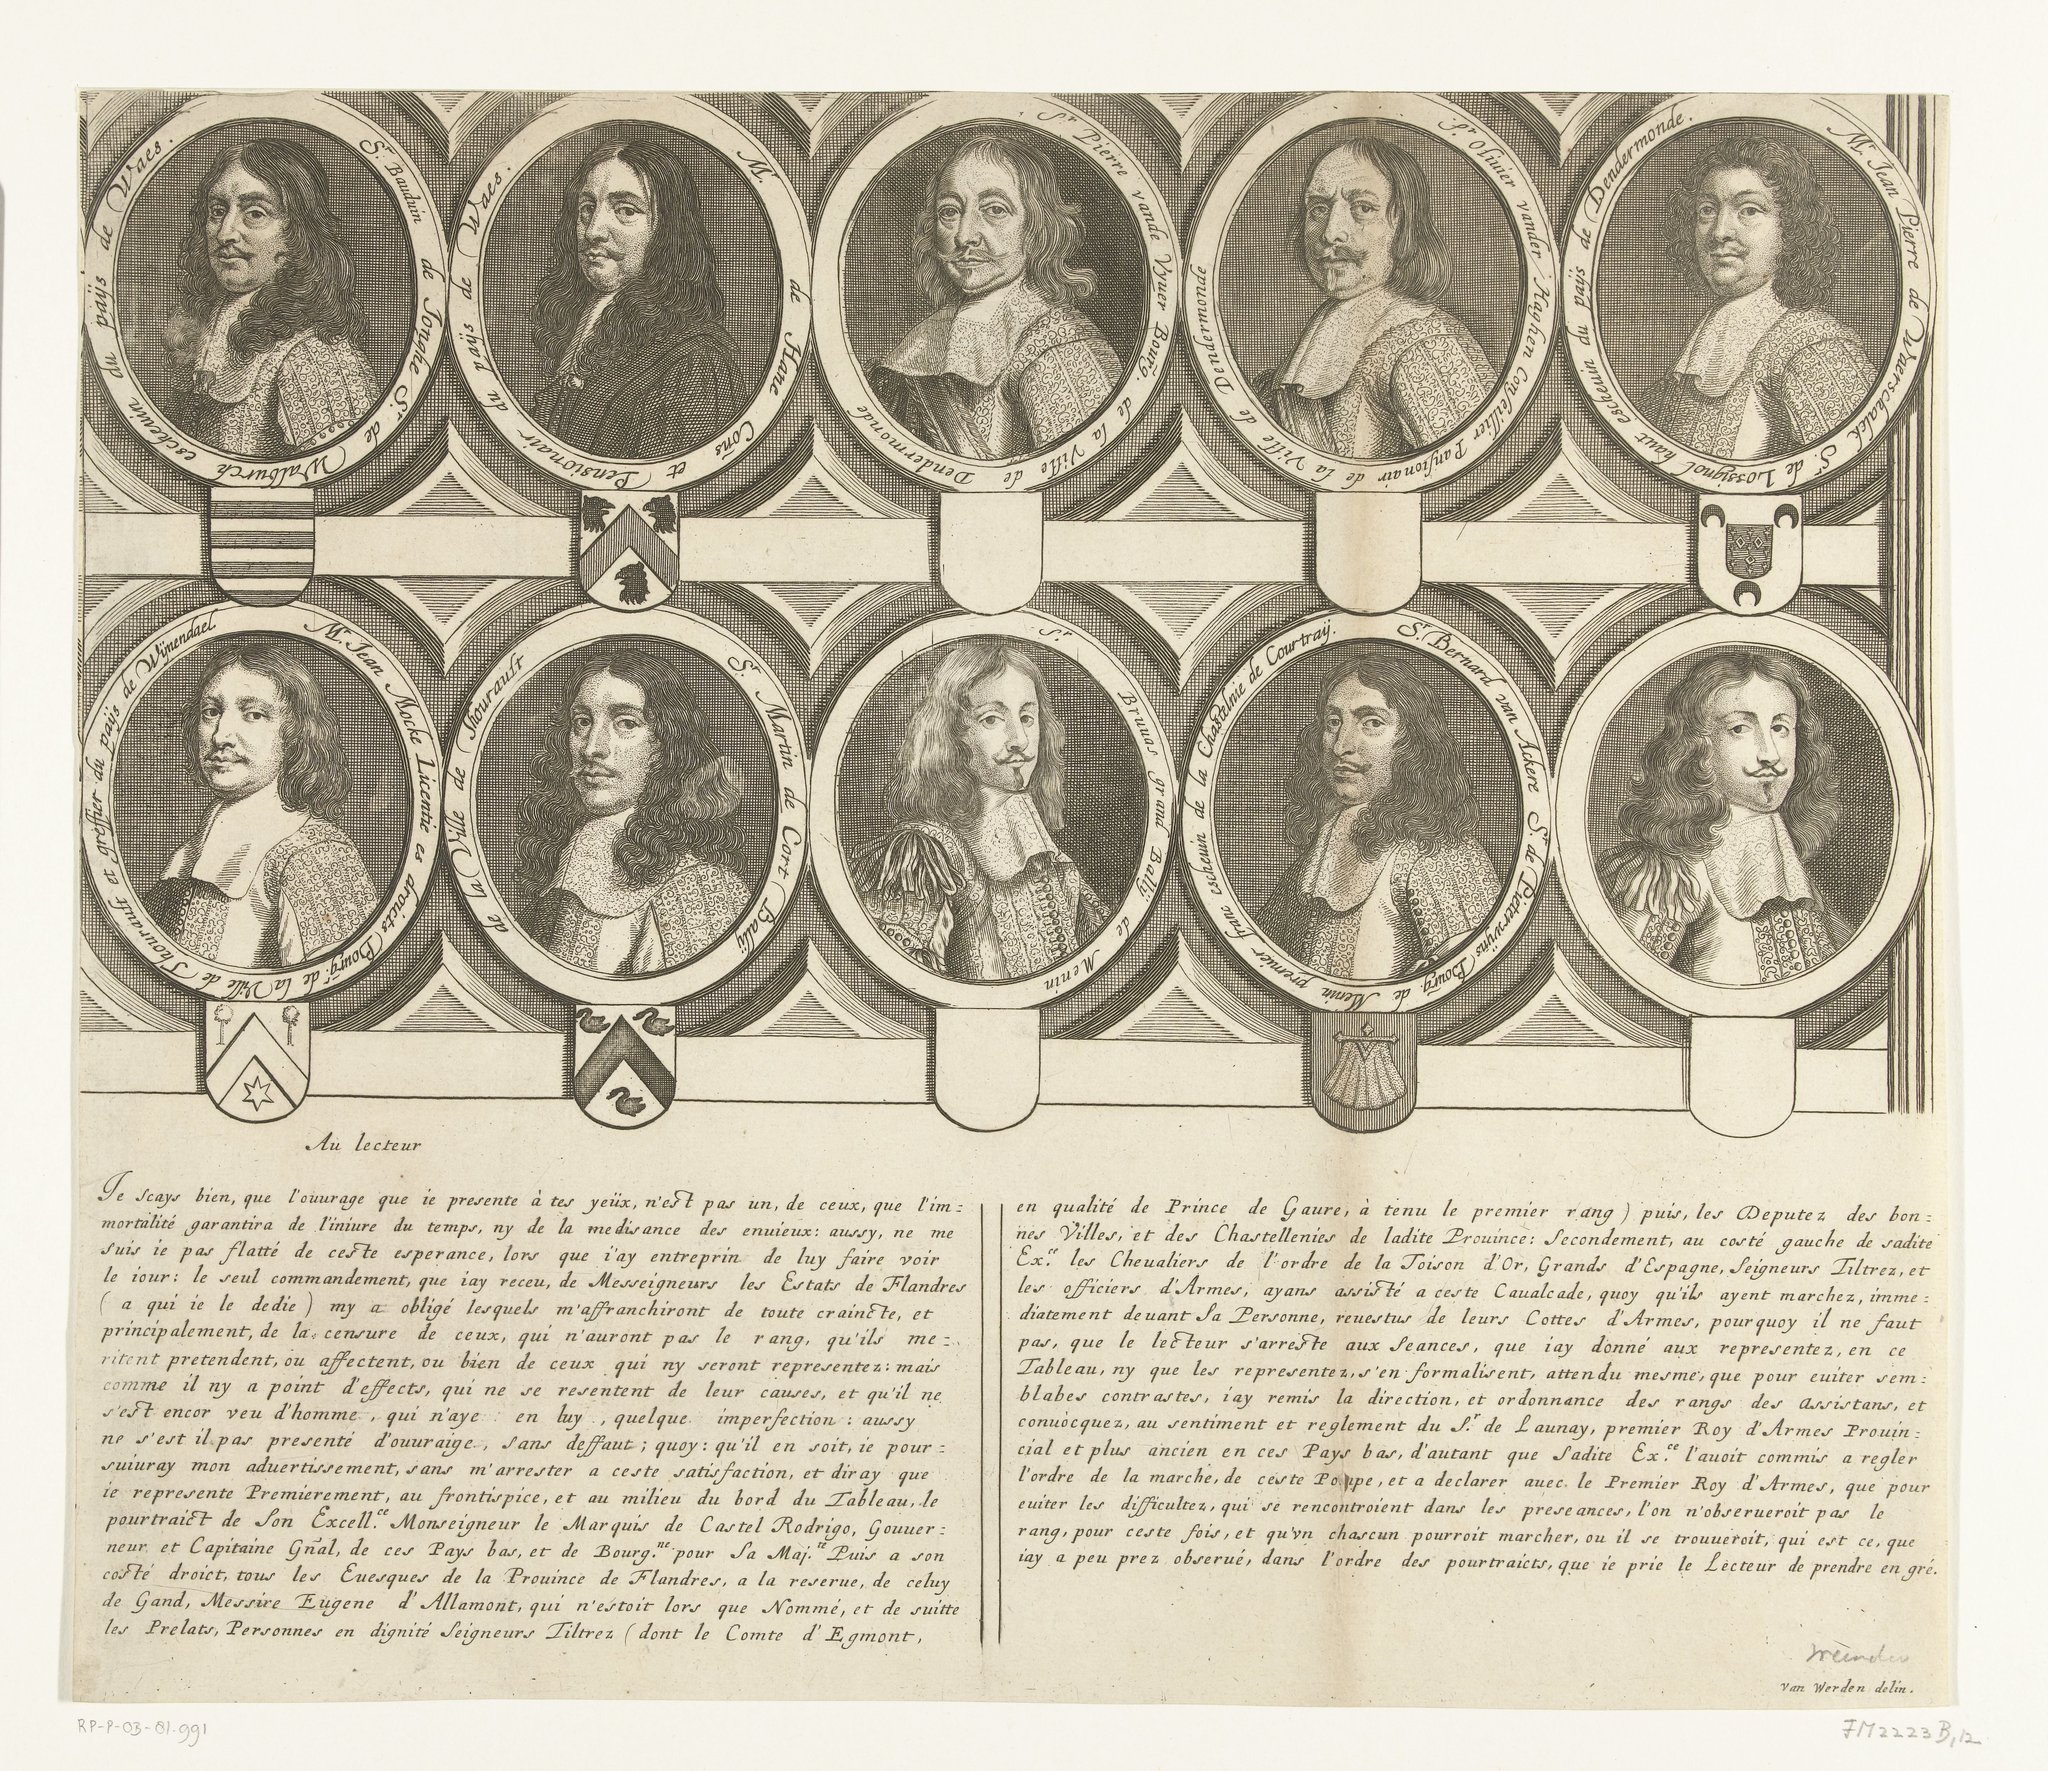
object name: print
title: Proclamatie te Gent van Karel II van Spanje als graaf van Vlaanderen (blad 12), 1666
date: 1666-1667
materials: paper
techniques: engraving, etching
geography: southern netherlands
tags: karel ii (koning van spanje)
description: Ceremonie op de Vrijdagmarkt te Gent bij de proclamatie van de Spaanse koning Karel II als graaf van Vlaanderen, 2 mei 1666. Blad 12 in een ongemonteerde ensemble van 12 platen van de ceremonie en cavalcade op het plein en 118 portretten van de hoogwaardigheidsbekleders die bij de plechtigheid aanwezig waren. Onderaan 2 kolommen tekst in het Frans.